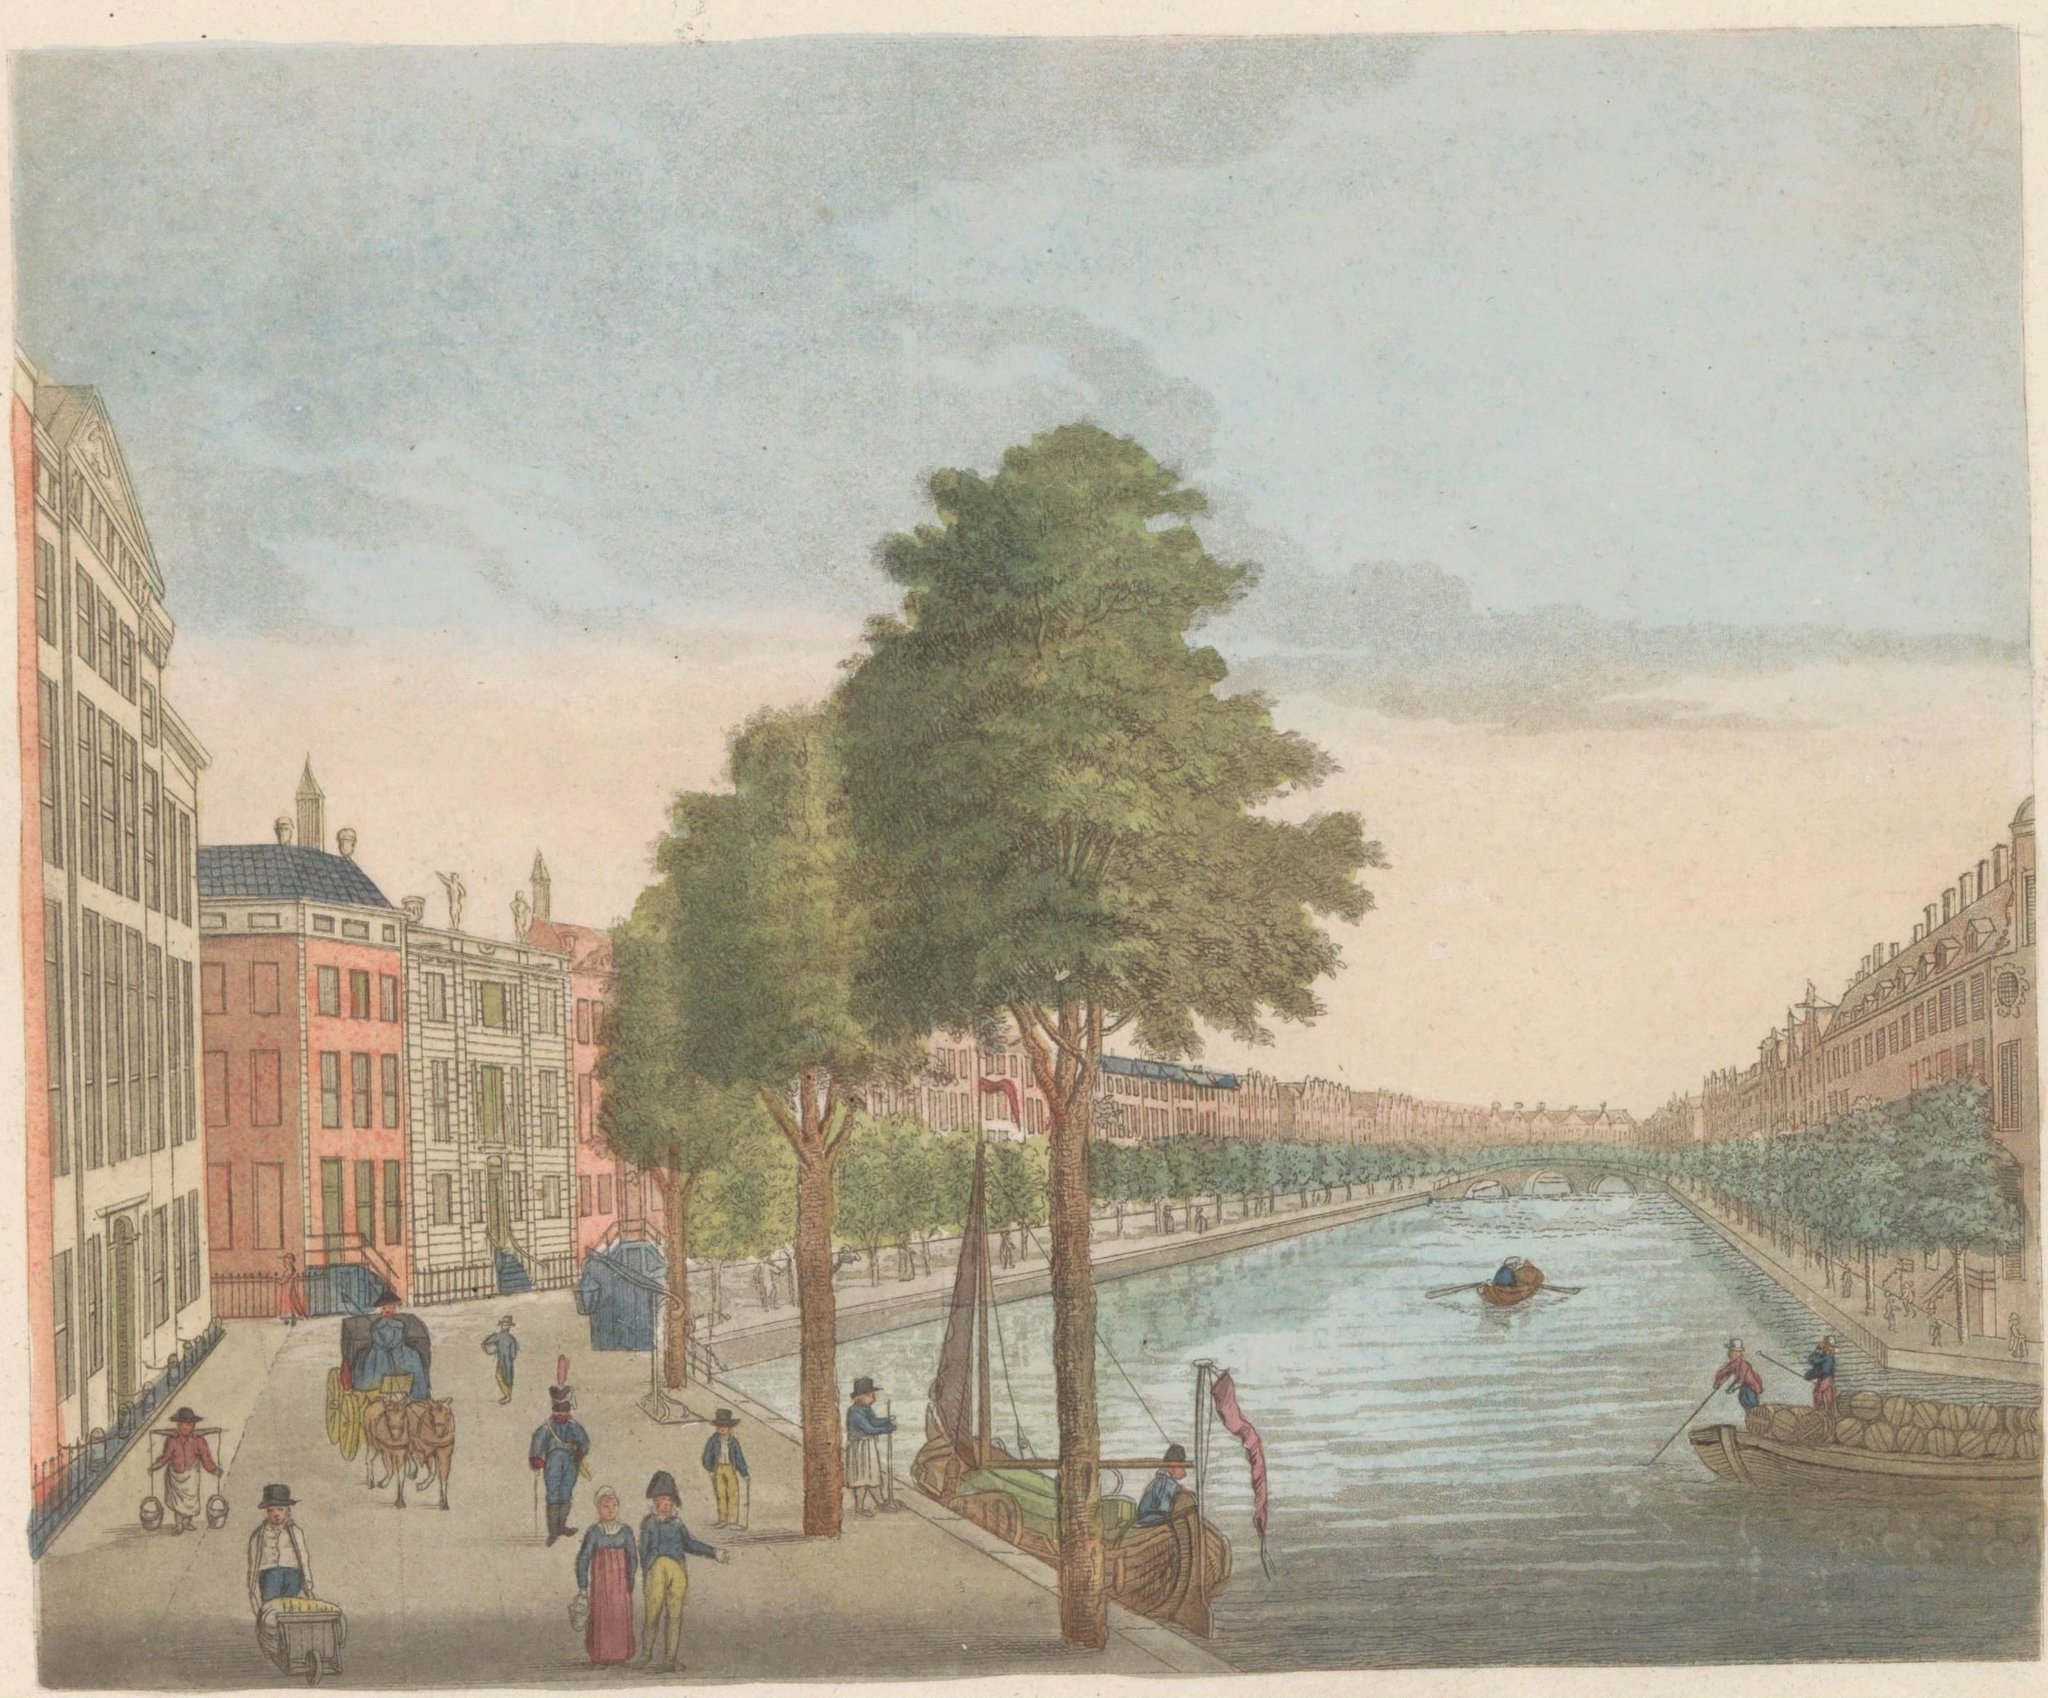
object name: print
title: Vue du Heere-Gracht, prise du Spiegel-Straat, jusqu'au Leidsche-Gracht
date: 1810-1813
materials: paper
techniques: aquatint, engraving, etching, hand coloring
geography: amsterdam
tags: nieuwe spiegelstraat, herengracht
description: De Herengracht, gezien vanaf de Nieuwe Spiegelstraat in de richting van de Leidsestraat, te Amsterdam, ca. 1810-1813. Onderdeel van een plaatwerk uit ca. 1824-1825 met 74 (ongenummerde) platen van de belangrijkste topografische gezichten en verschillende zeden en gewoonten in het Verenigd Koninkrijk der Nederlanden.